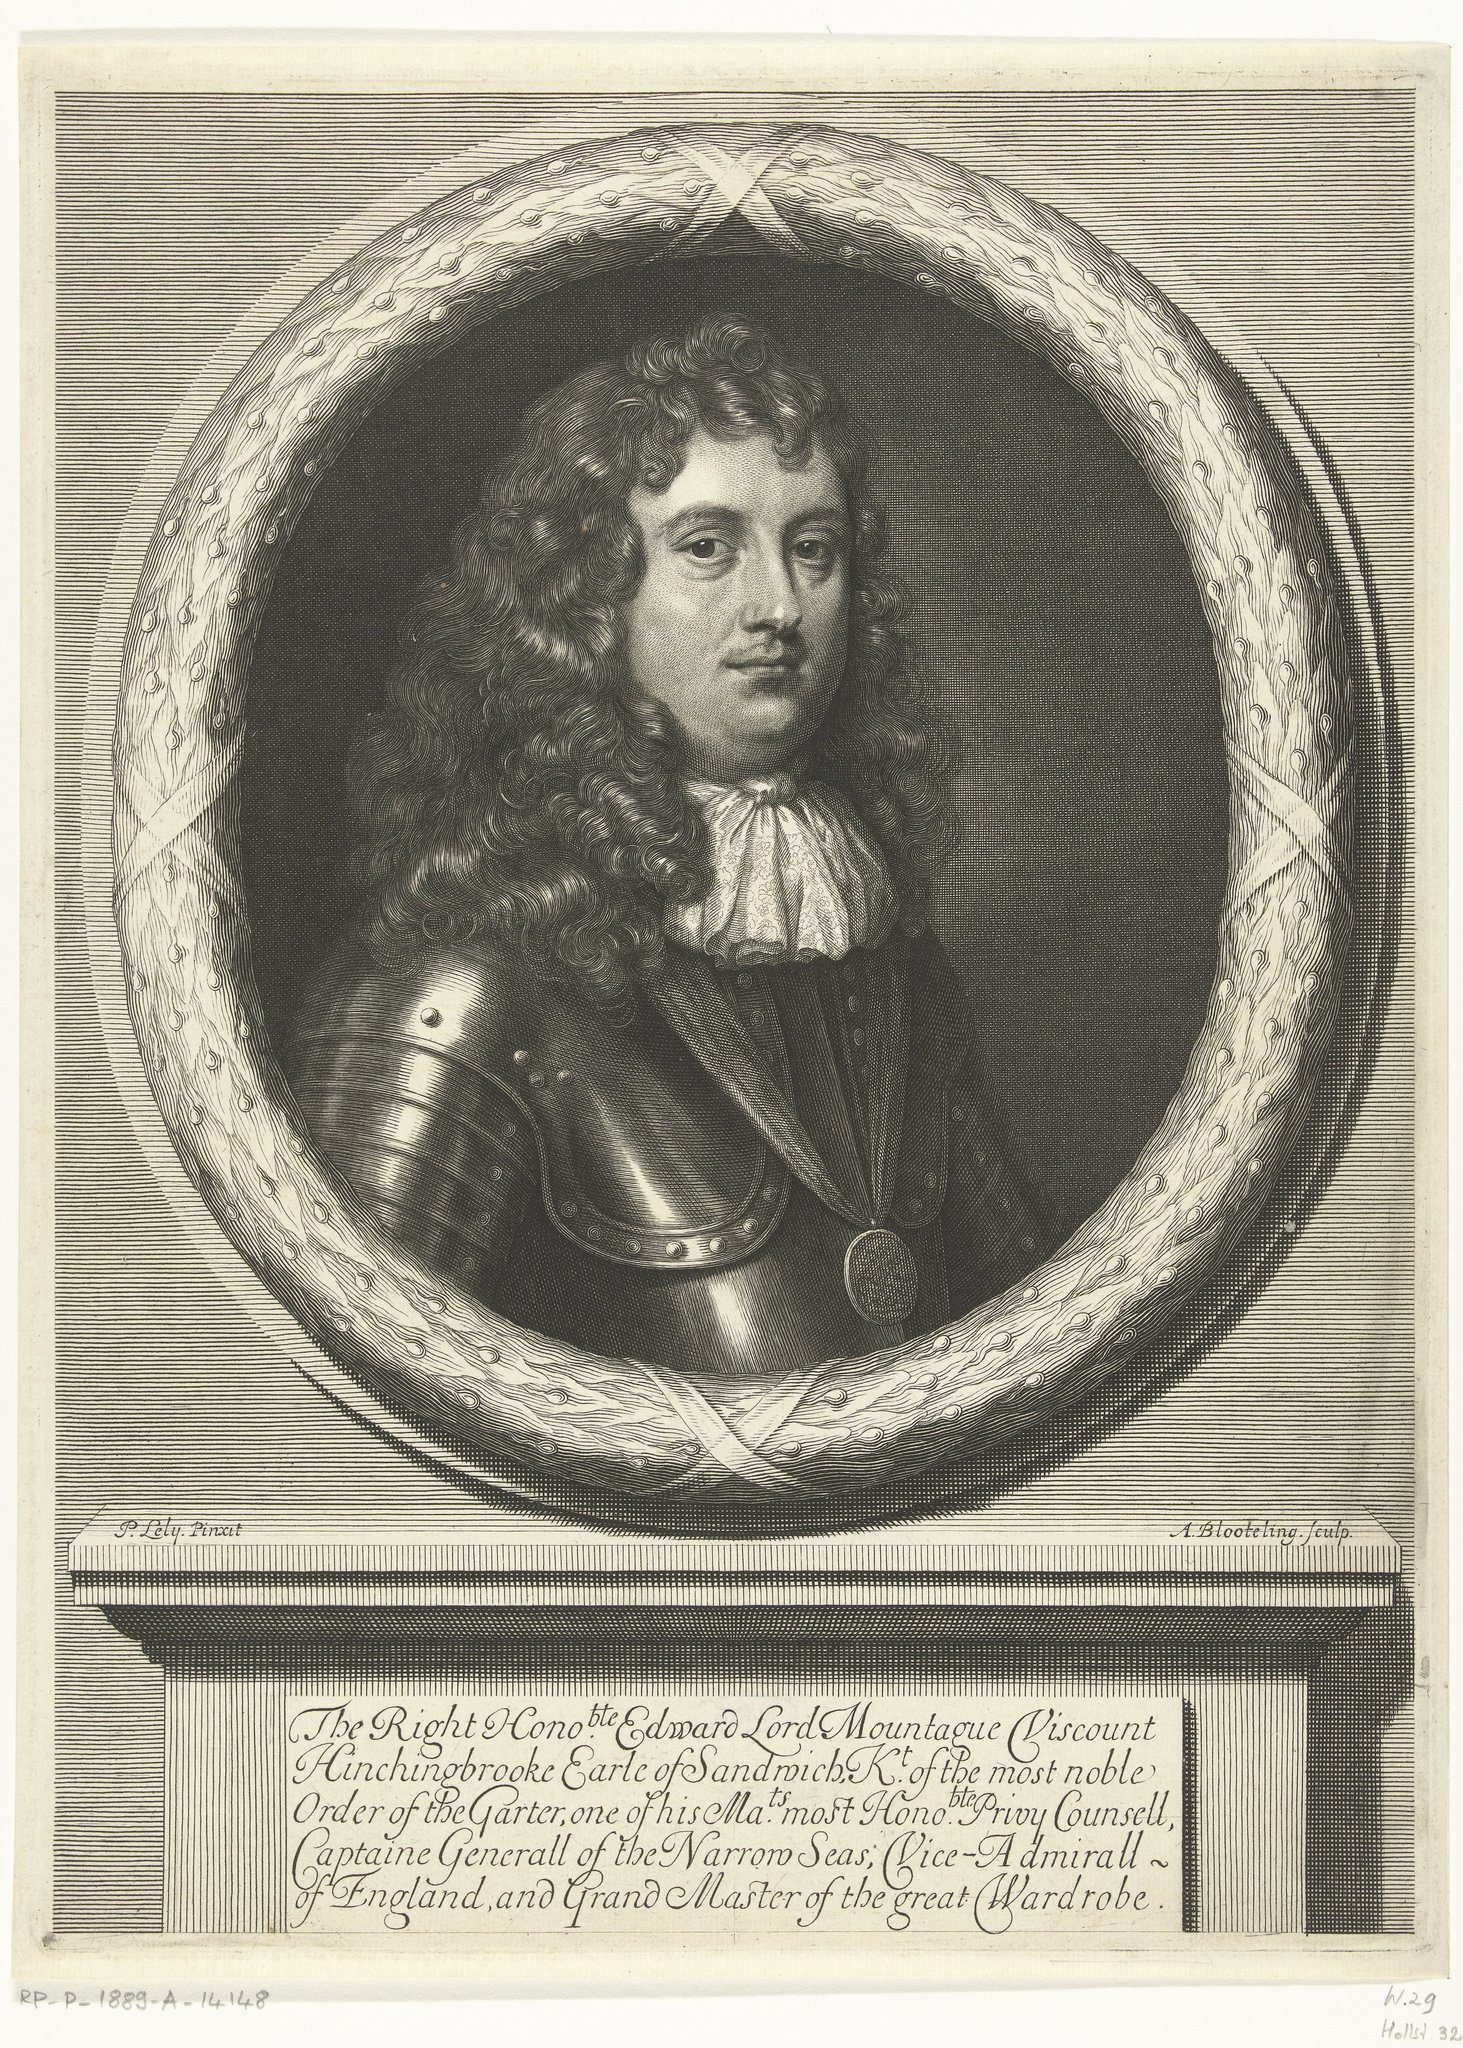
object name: print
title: Portret van Edward Montagu (I) graaf van Sandwich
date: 1655-1690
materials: paper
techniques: engraving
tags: edward montagu (1st earl of sandwich)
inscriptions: collector's mark: Lugt 2228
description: Portret van de Engelse aristocraat Edward Montagu (I) graaf van Sandwich in een ovale omlijsting uit lauwerbladeren. Onder het portret, op een sokkel, staan zijn naam en titels.